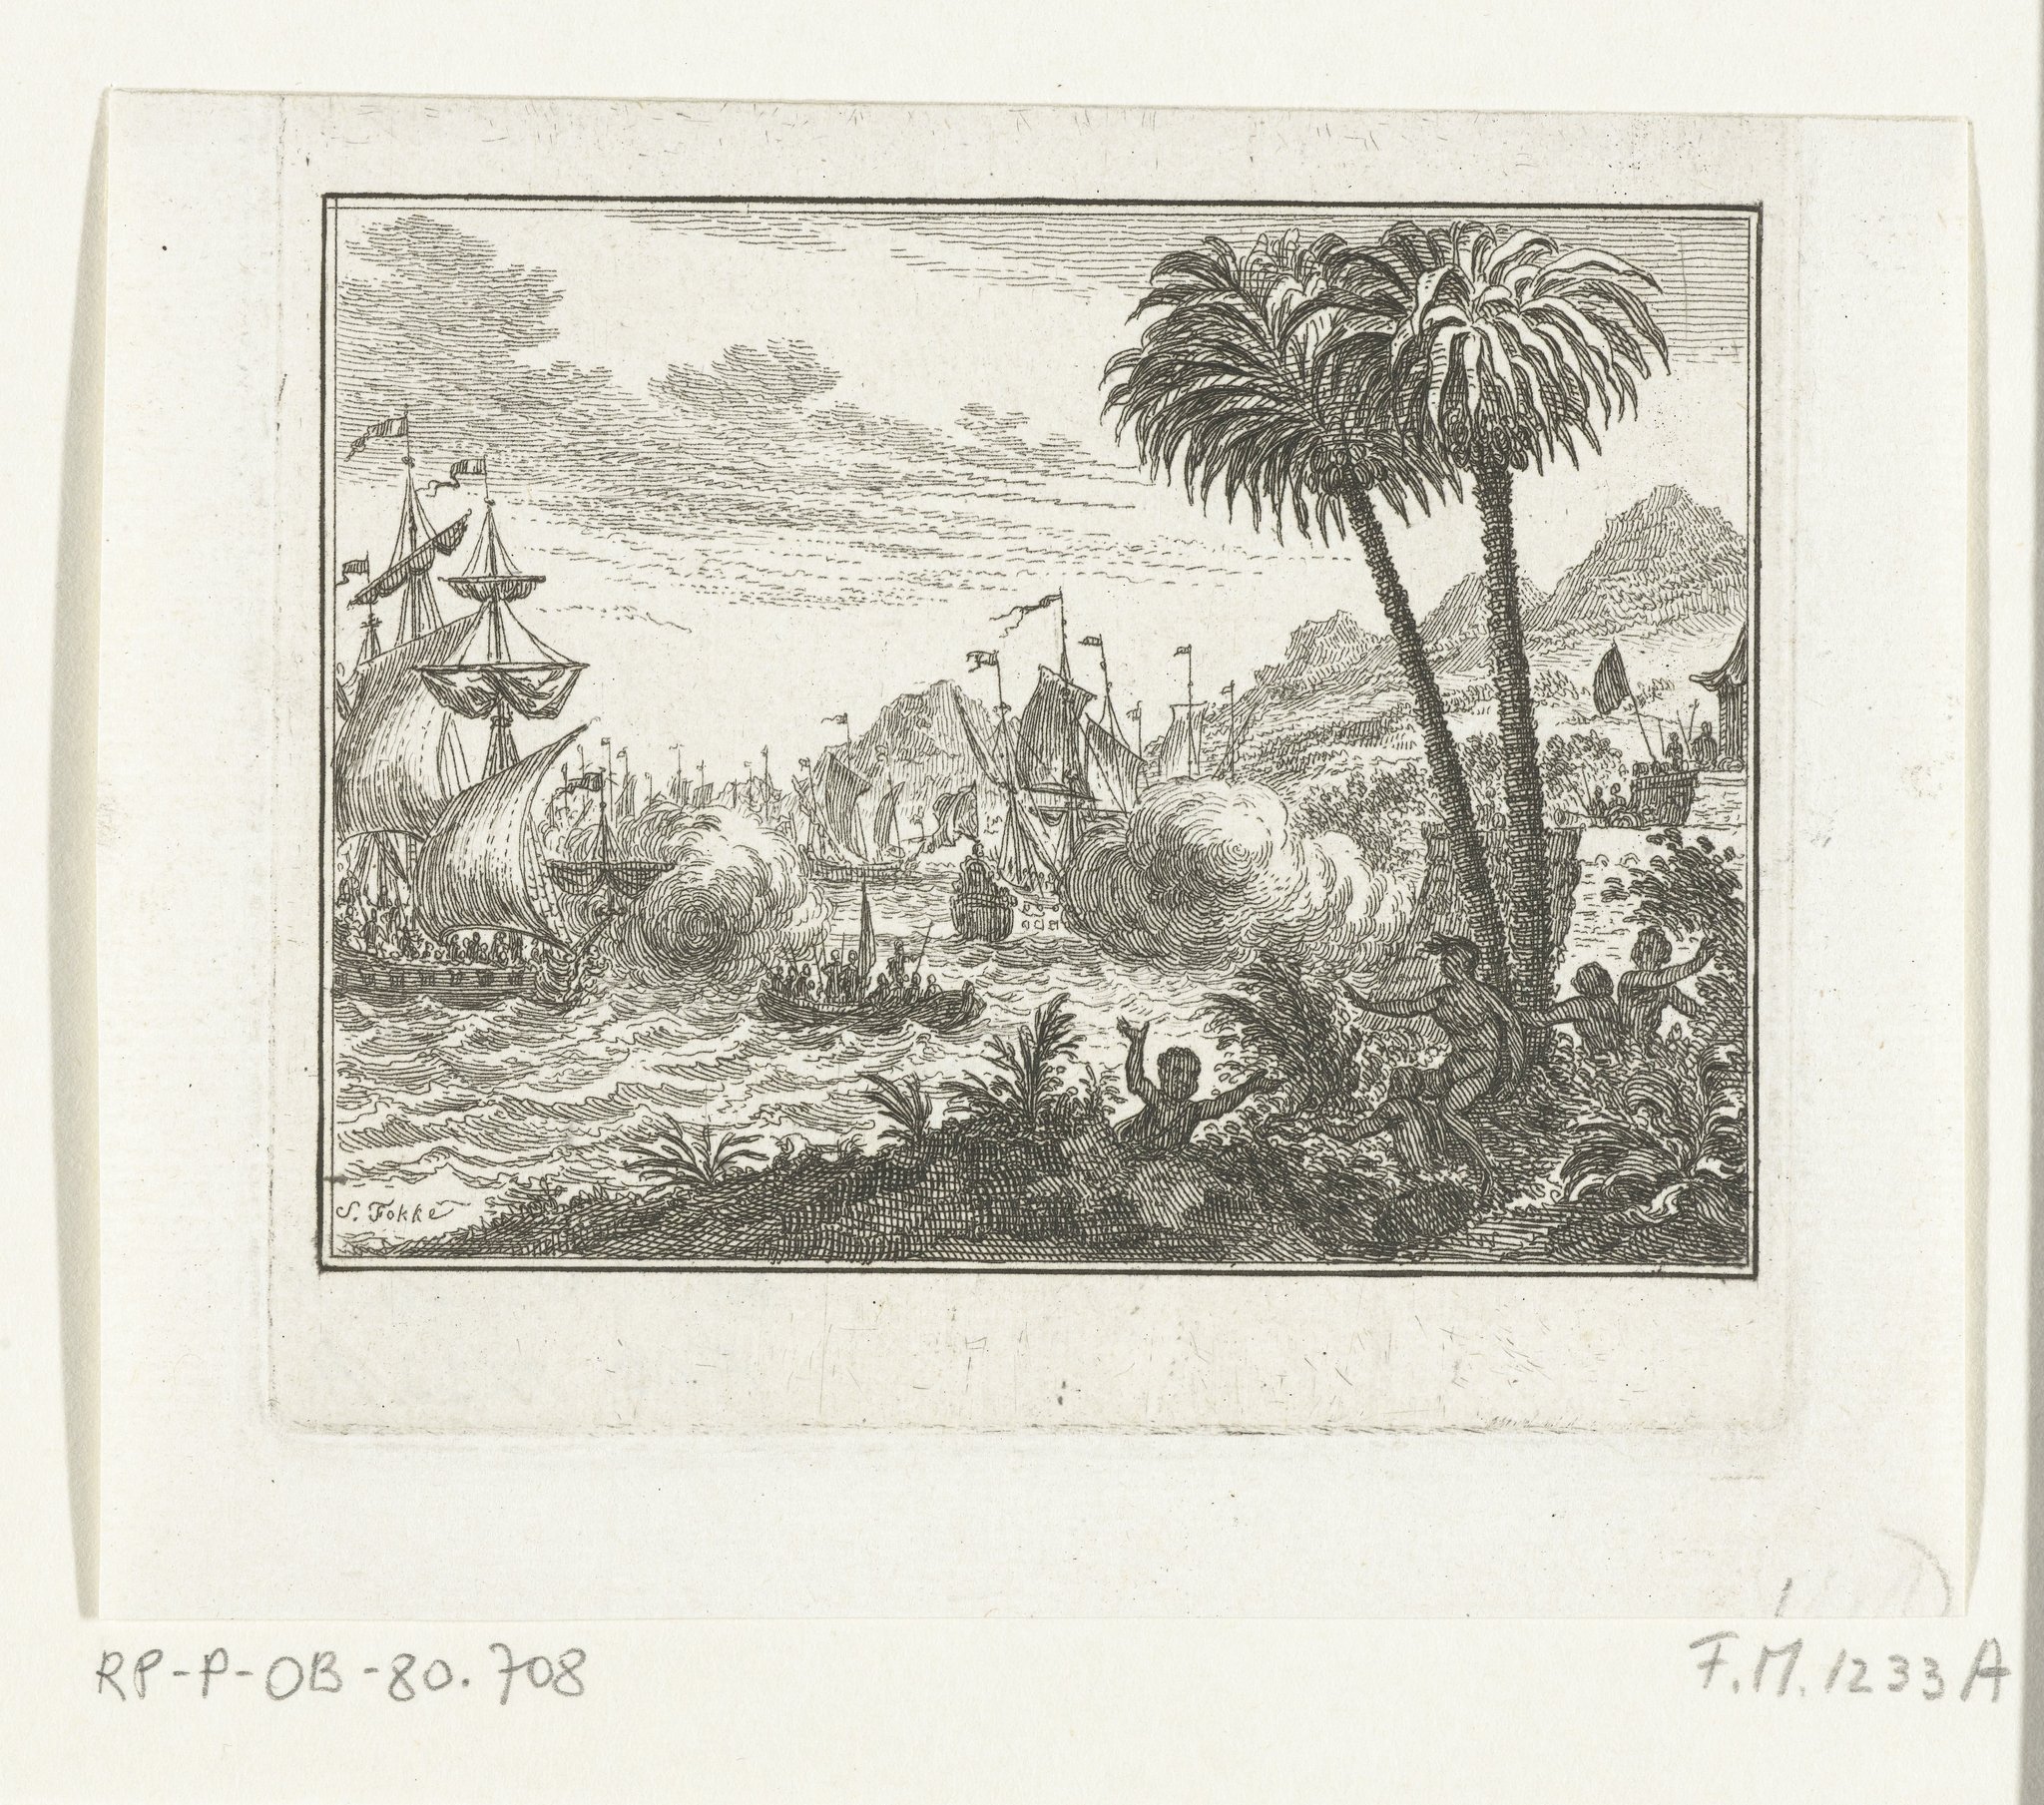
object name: history print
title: Verovering van Ambon, 1606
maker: simon fokke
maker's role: draughtsman, print maker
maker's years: 1712-1784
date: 1782-1784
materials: paper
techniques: etching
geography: northern netherlands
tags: capture of city (after the siege)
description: Gebruikt als illustratie in: J.W. te Water, De vaderlandsche Historie van den heere J. Wagenaar, verkort, en met leerzaame aanmerkingen, ten dienste der Nederlandsche jeugd, 1784-1800, 4 delen. Niet in Frederik Muller; door het RPK toegevoegd nummer.